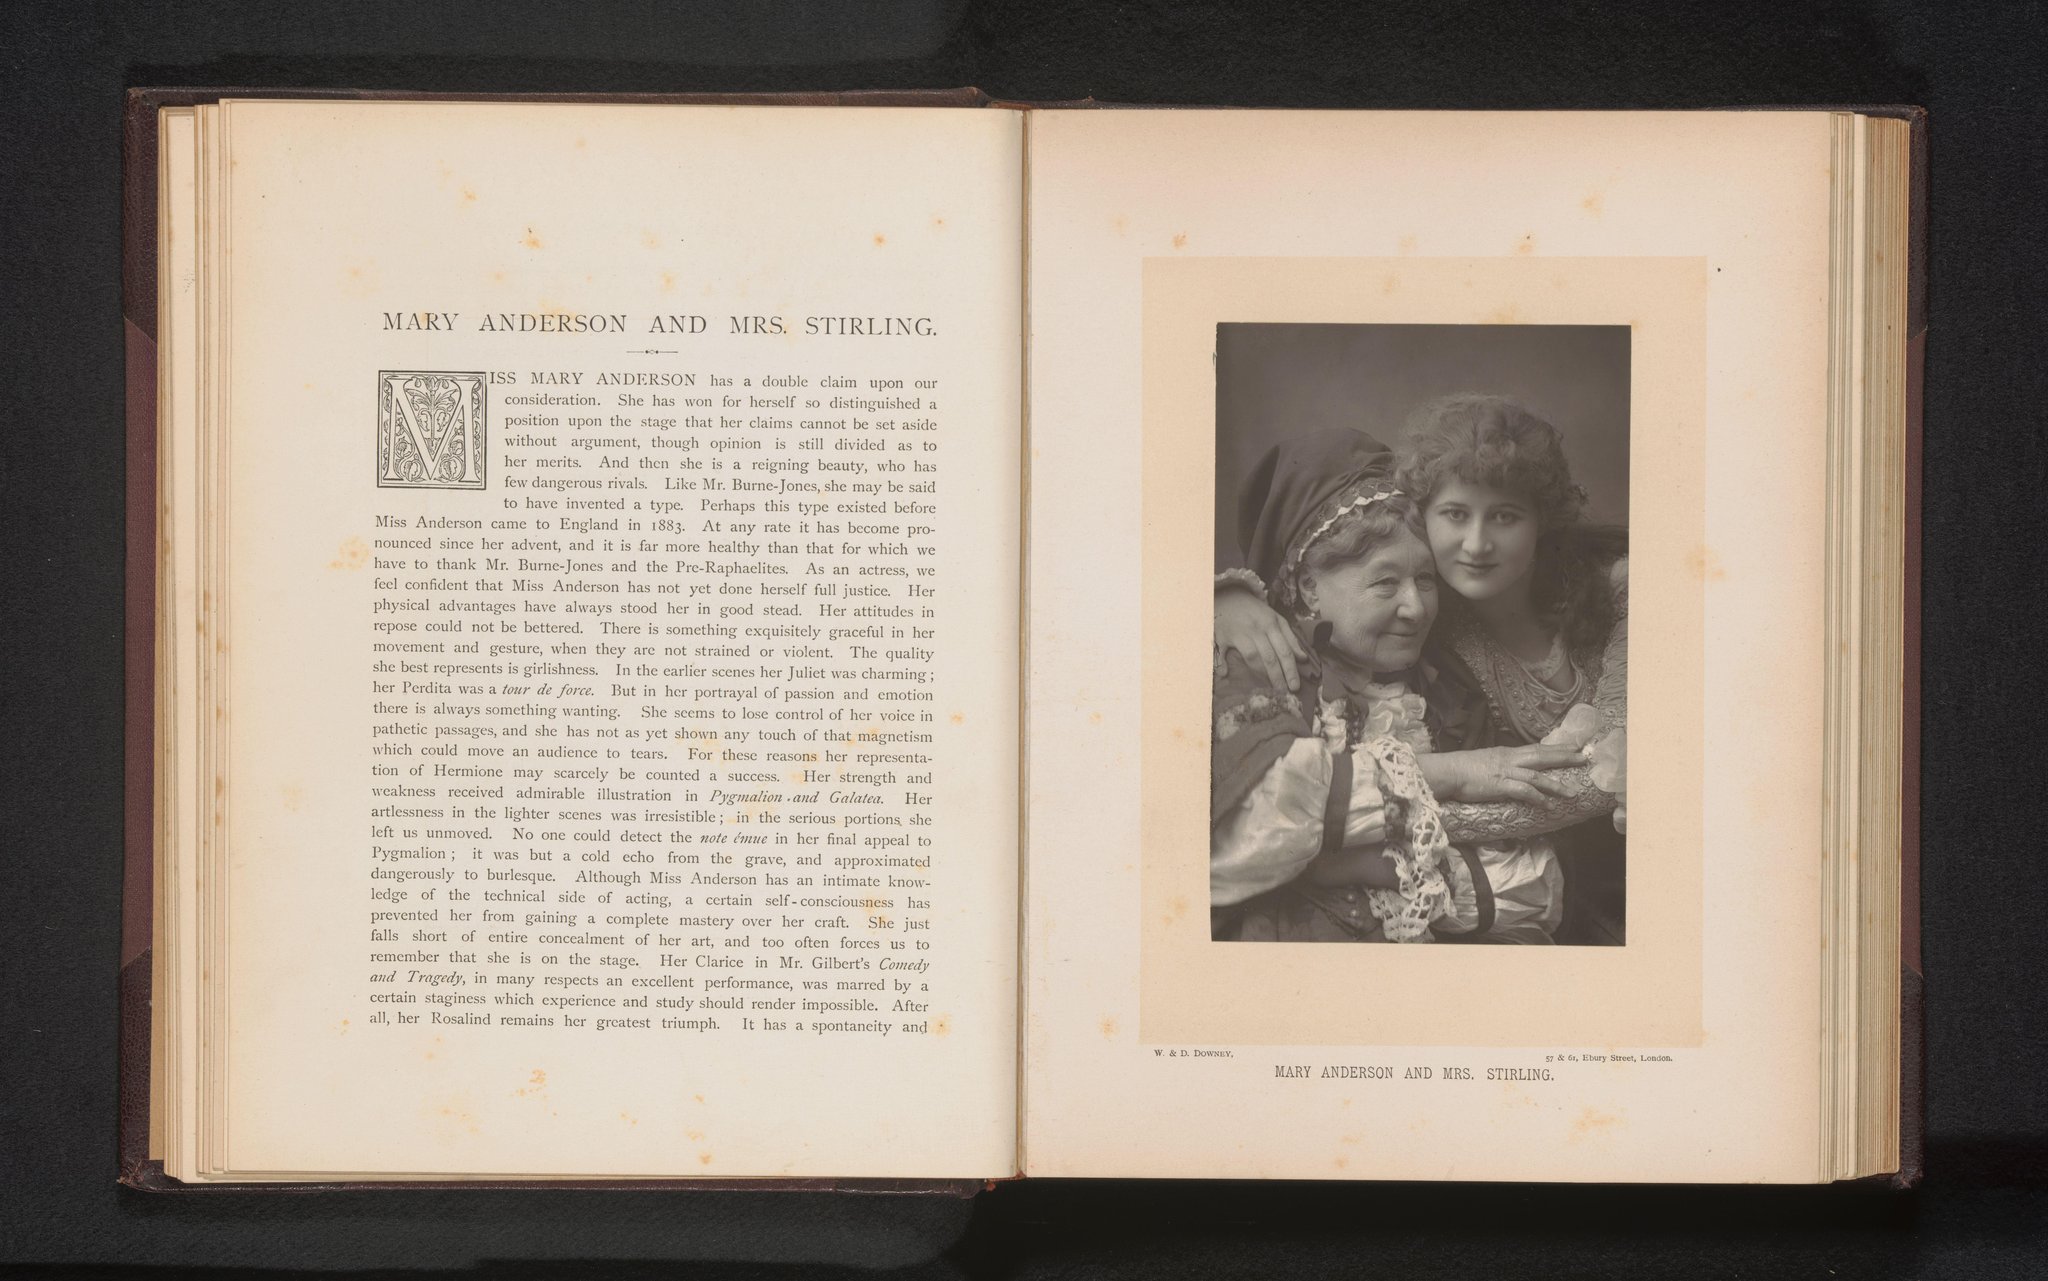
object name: photograph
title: Portret van Mary Anderson en Mary Anne Stirling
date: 1885-1890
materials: paper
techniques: carbon print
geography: london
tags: historical persons - bb - woman, portrait of actor, actress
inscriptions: address: ‘57 & 61, Ebury Street, London.’